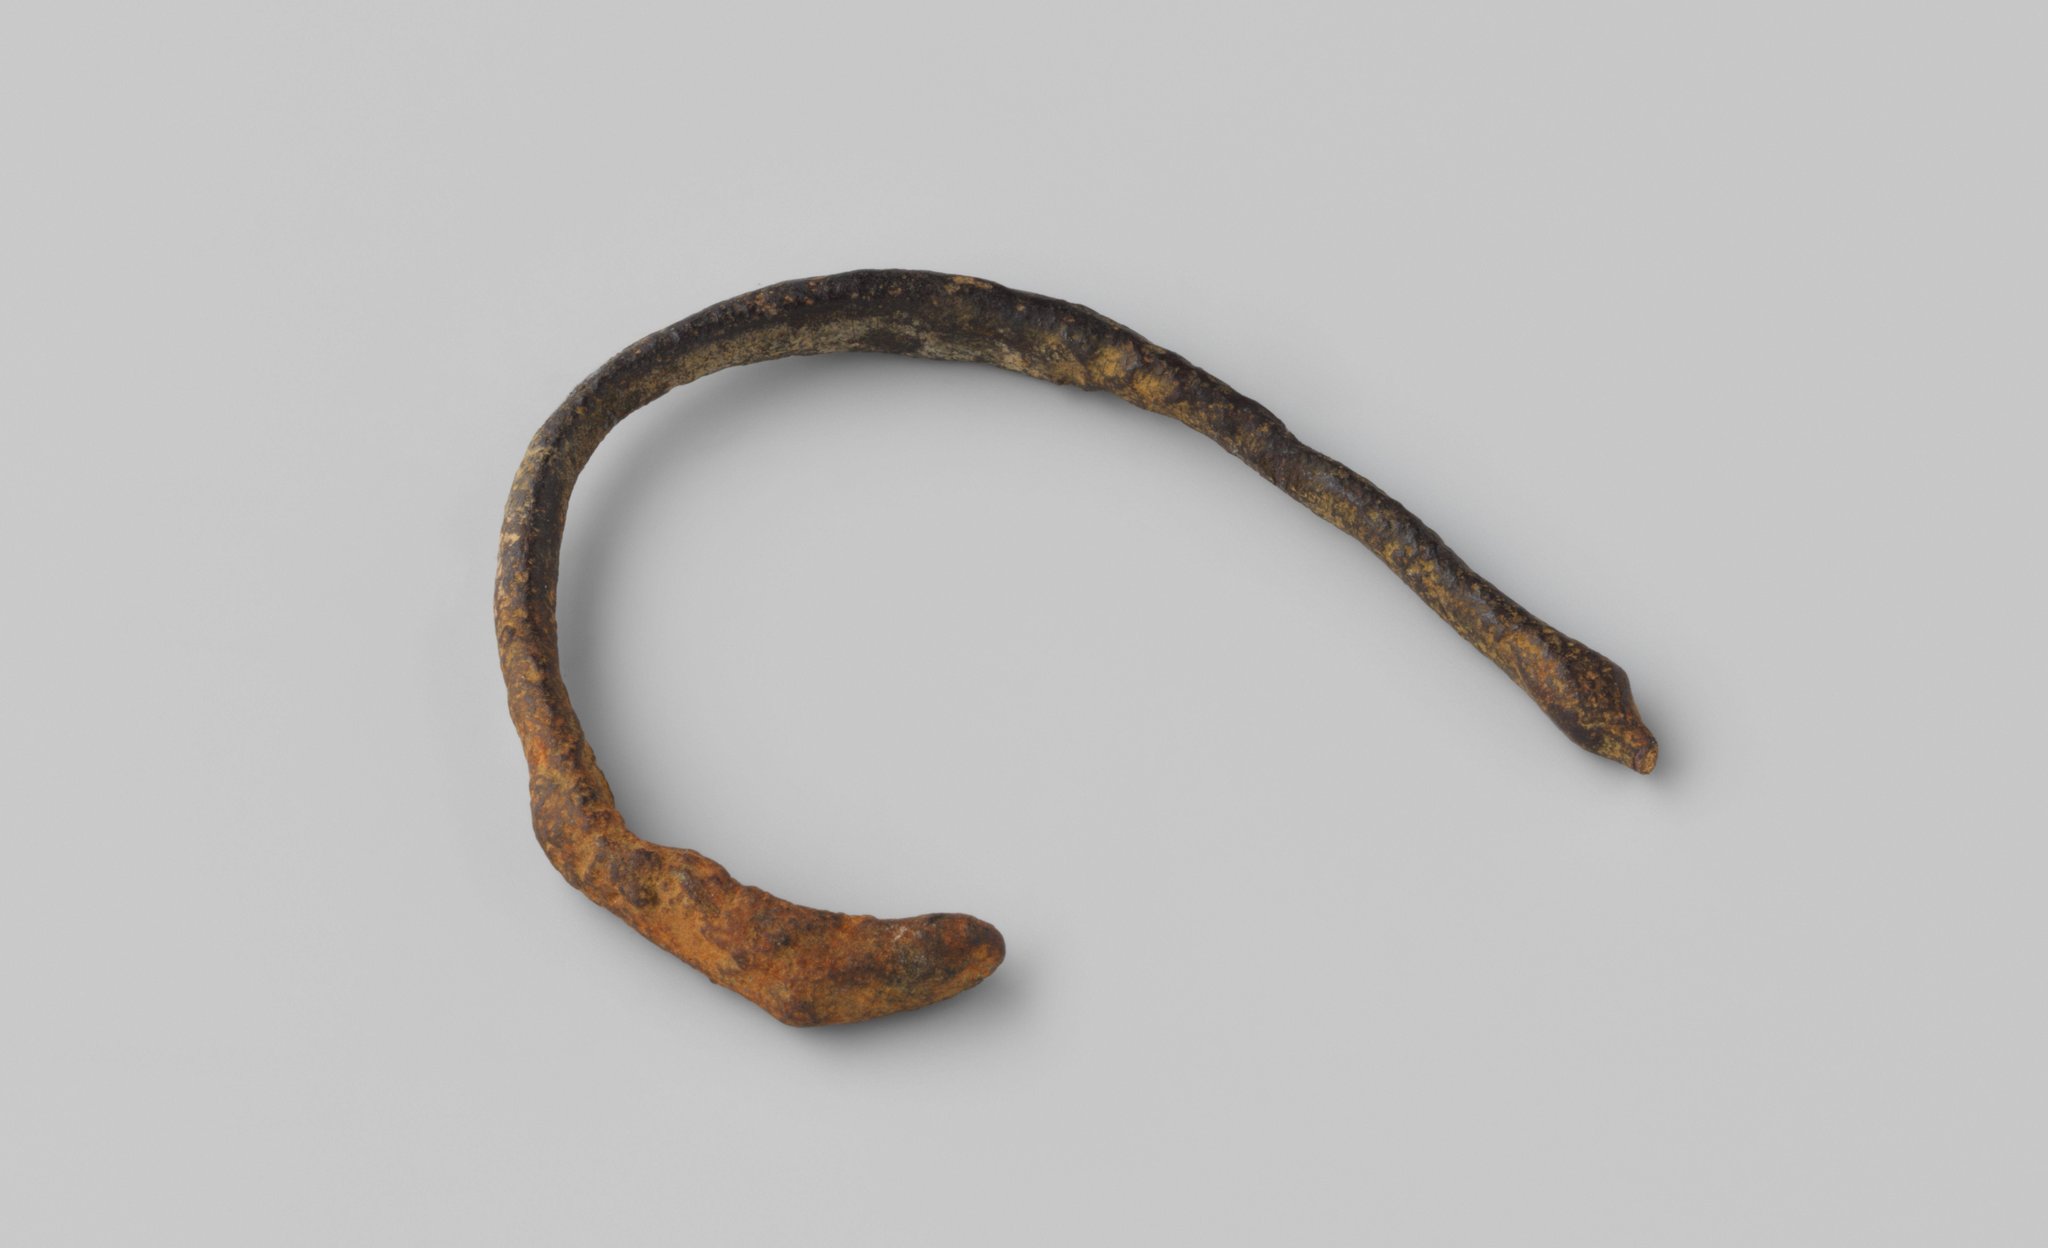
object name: part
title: Fragment of onderdeel uit het wrak van de Oost-Indiëvaarder Hollandia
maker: Anonymous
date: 1743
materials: copper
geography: netherlands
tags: verenigde oostindische compagnie, hollandia (schip), annet